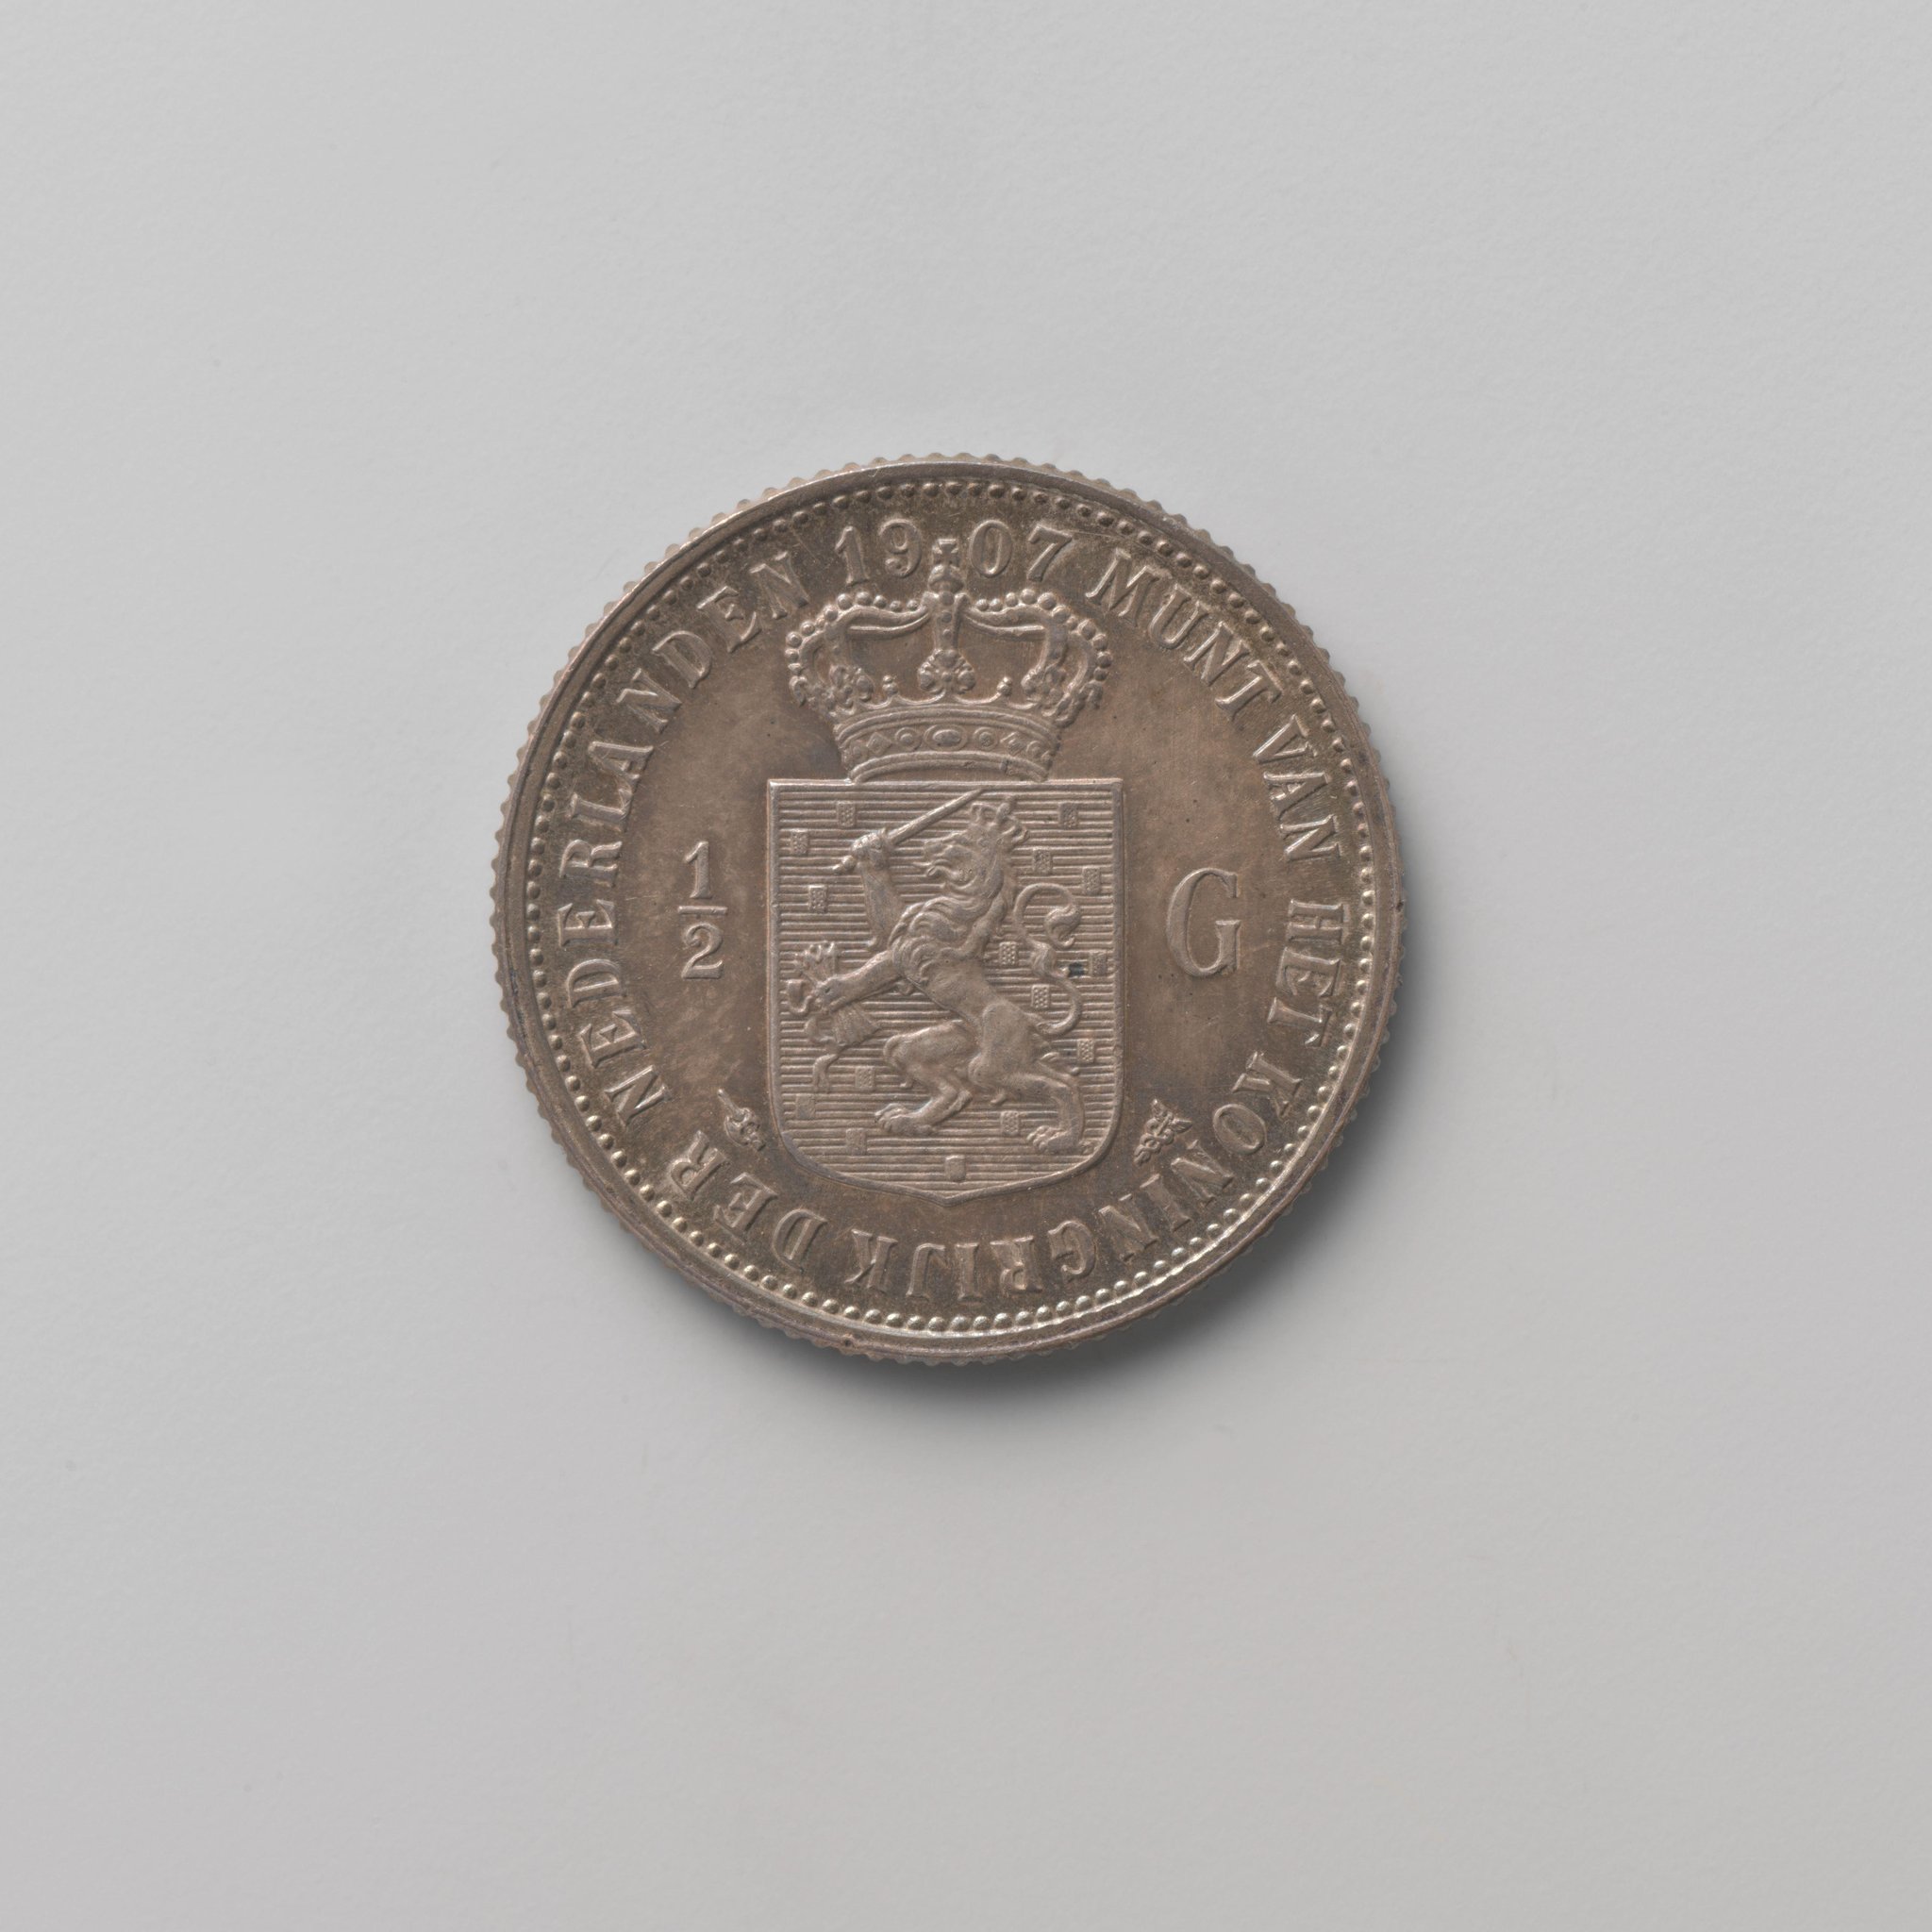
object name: coin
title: Nederland, ½ gulden,1907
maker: wilhelmina of the netherlands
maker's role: print maker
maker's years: 1880-1962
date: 1907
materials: silver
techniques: striking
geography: utrecht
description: Zilveren munt. Voorzijde: hoofd met diadeem naar links. Keerzijde: tussen waarde-aanduiding ½ G gekroond rijkswapenschild. Jaartal bovenaan in omschrift. Karteland.